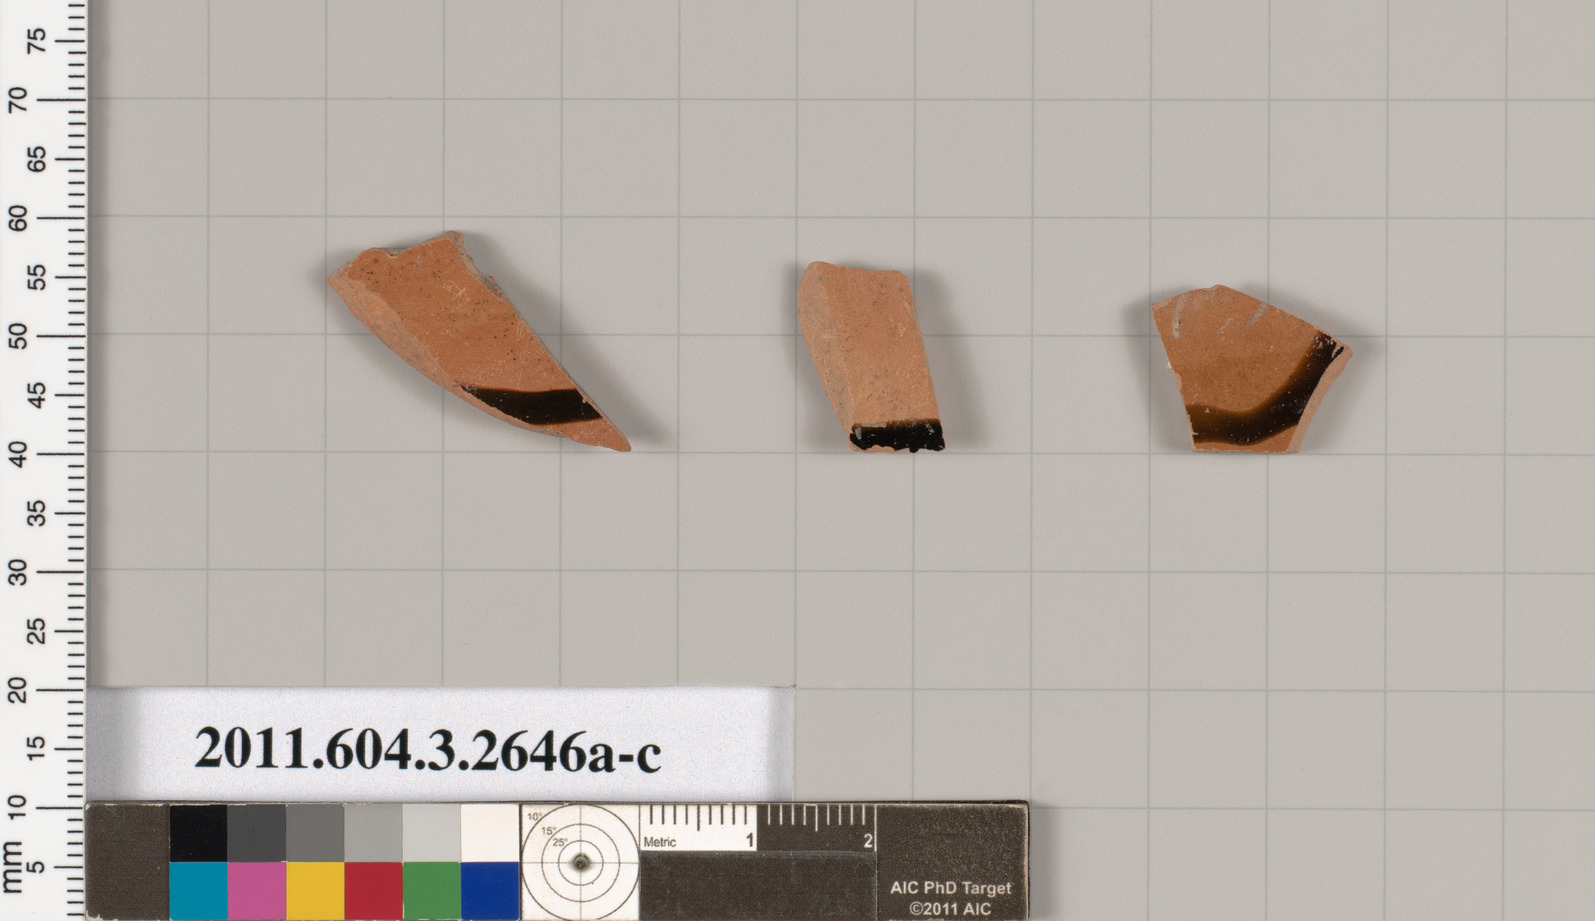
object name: kylix fragment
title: Terracotta fragments of kylikes (drinking cups)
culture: greek, attic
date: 534-501 BCE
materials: terracotta